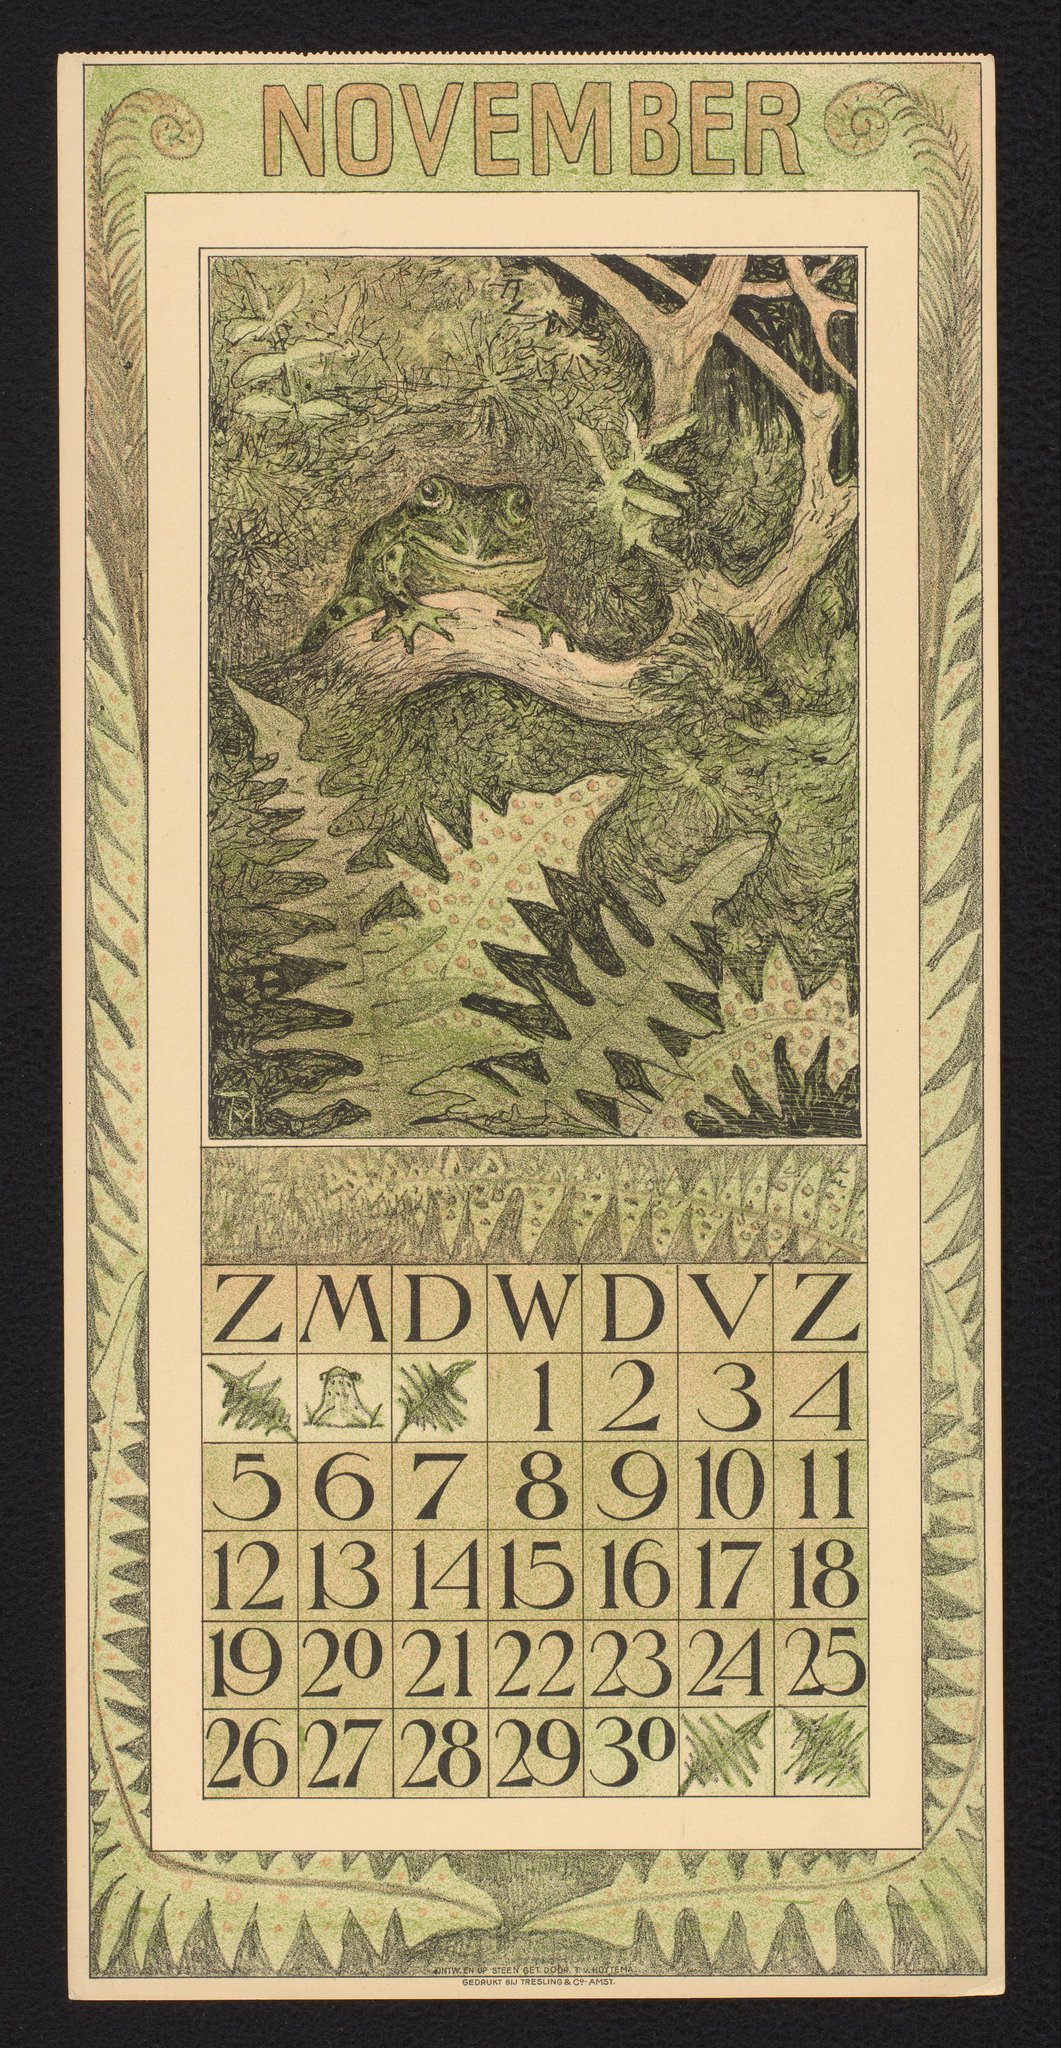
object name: calendar leaf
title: Kalenderblad voor november 1911 met een kikker in het bos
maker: theo van hoytema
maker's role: draughtsman, painter, print maker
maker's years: 1863-1917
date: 1910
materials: paper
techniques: lithograph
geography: amsterdam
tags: tailless amphibians: frog, calendar, almanac, forest, wood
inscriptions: collector's mark: Lugt 2228